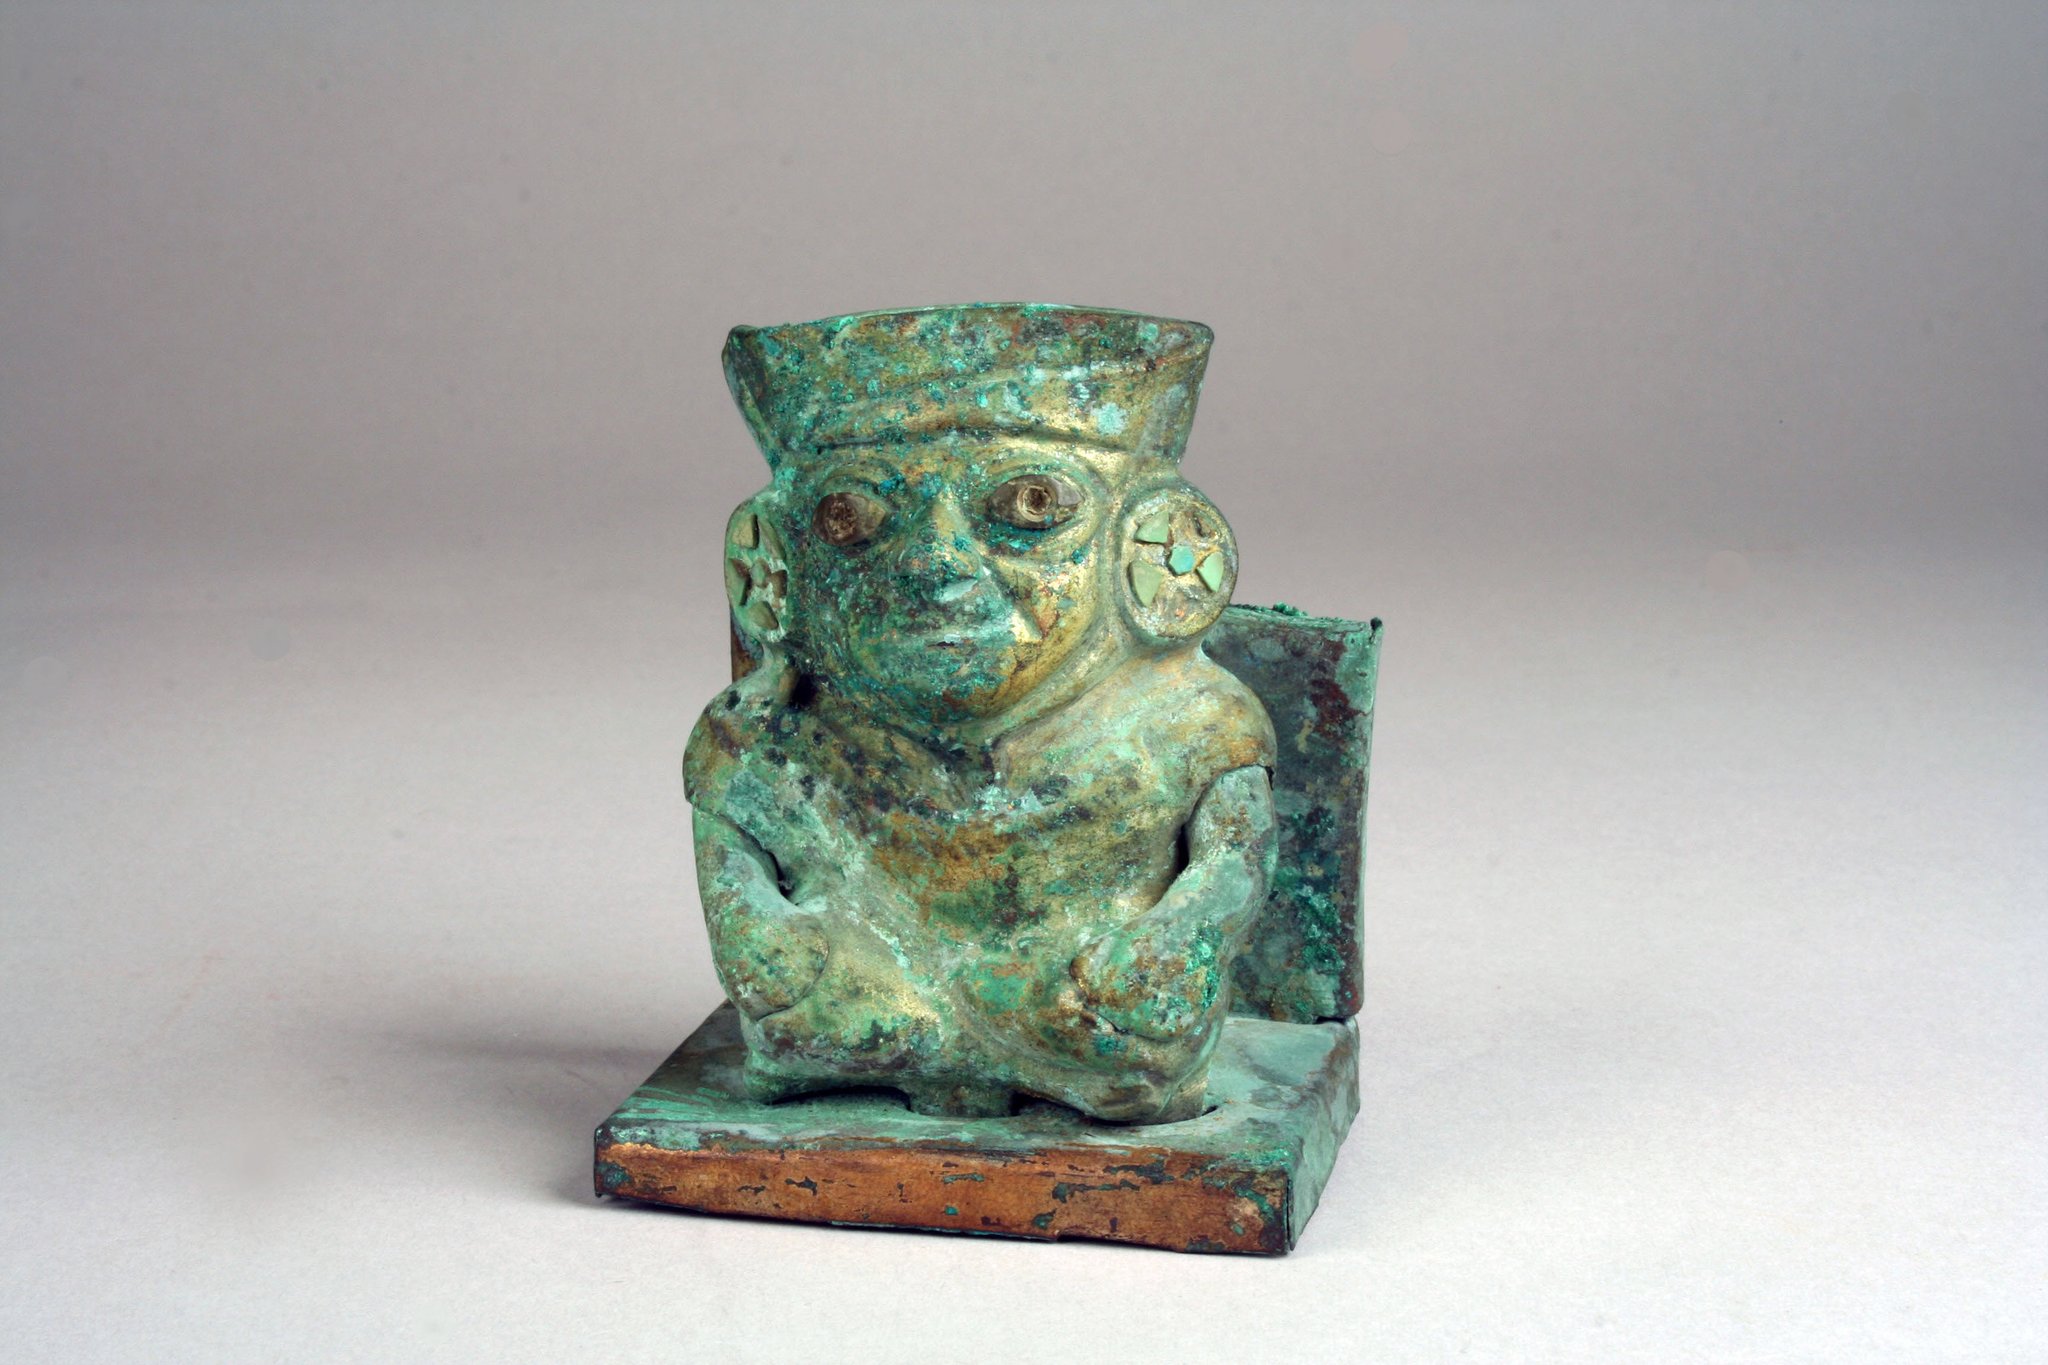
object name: staff head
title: Seated Figure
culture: moche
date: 501-700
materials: gilt copper, stone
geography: peru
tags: men